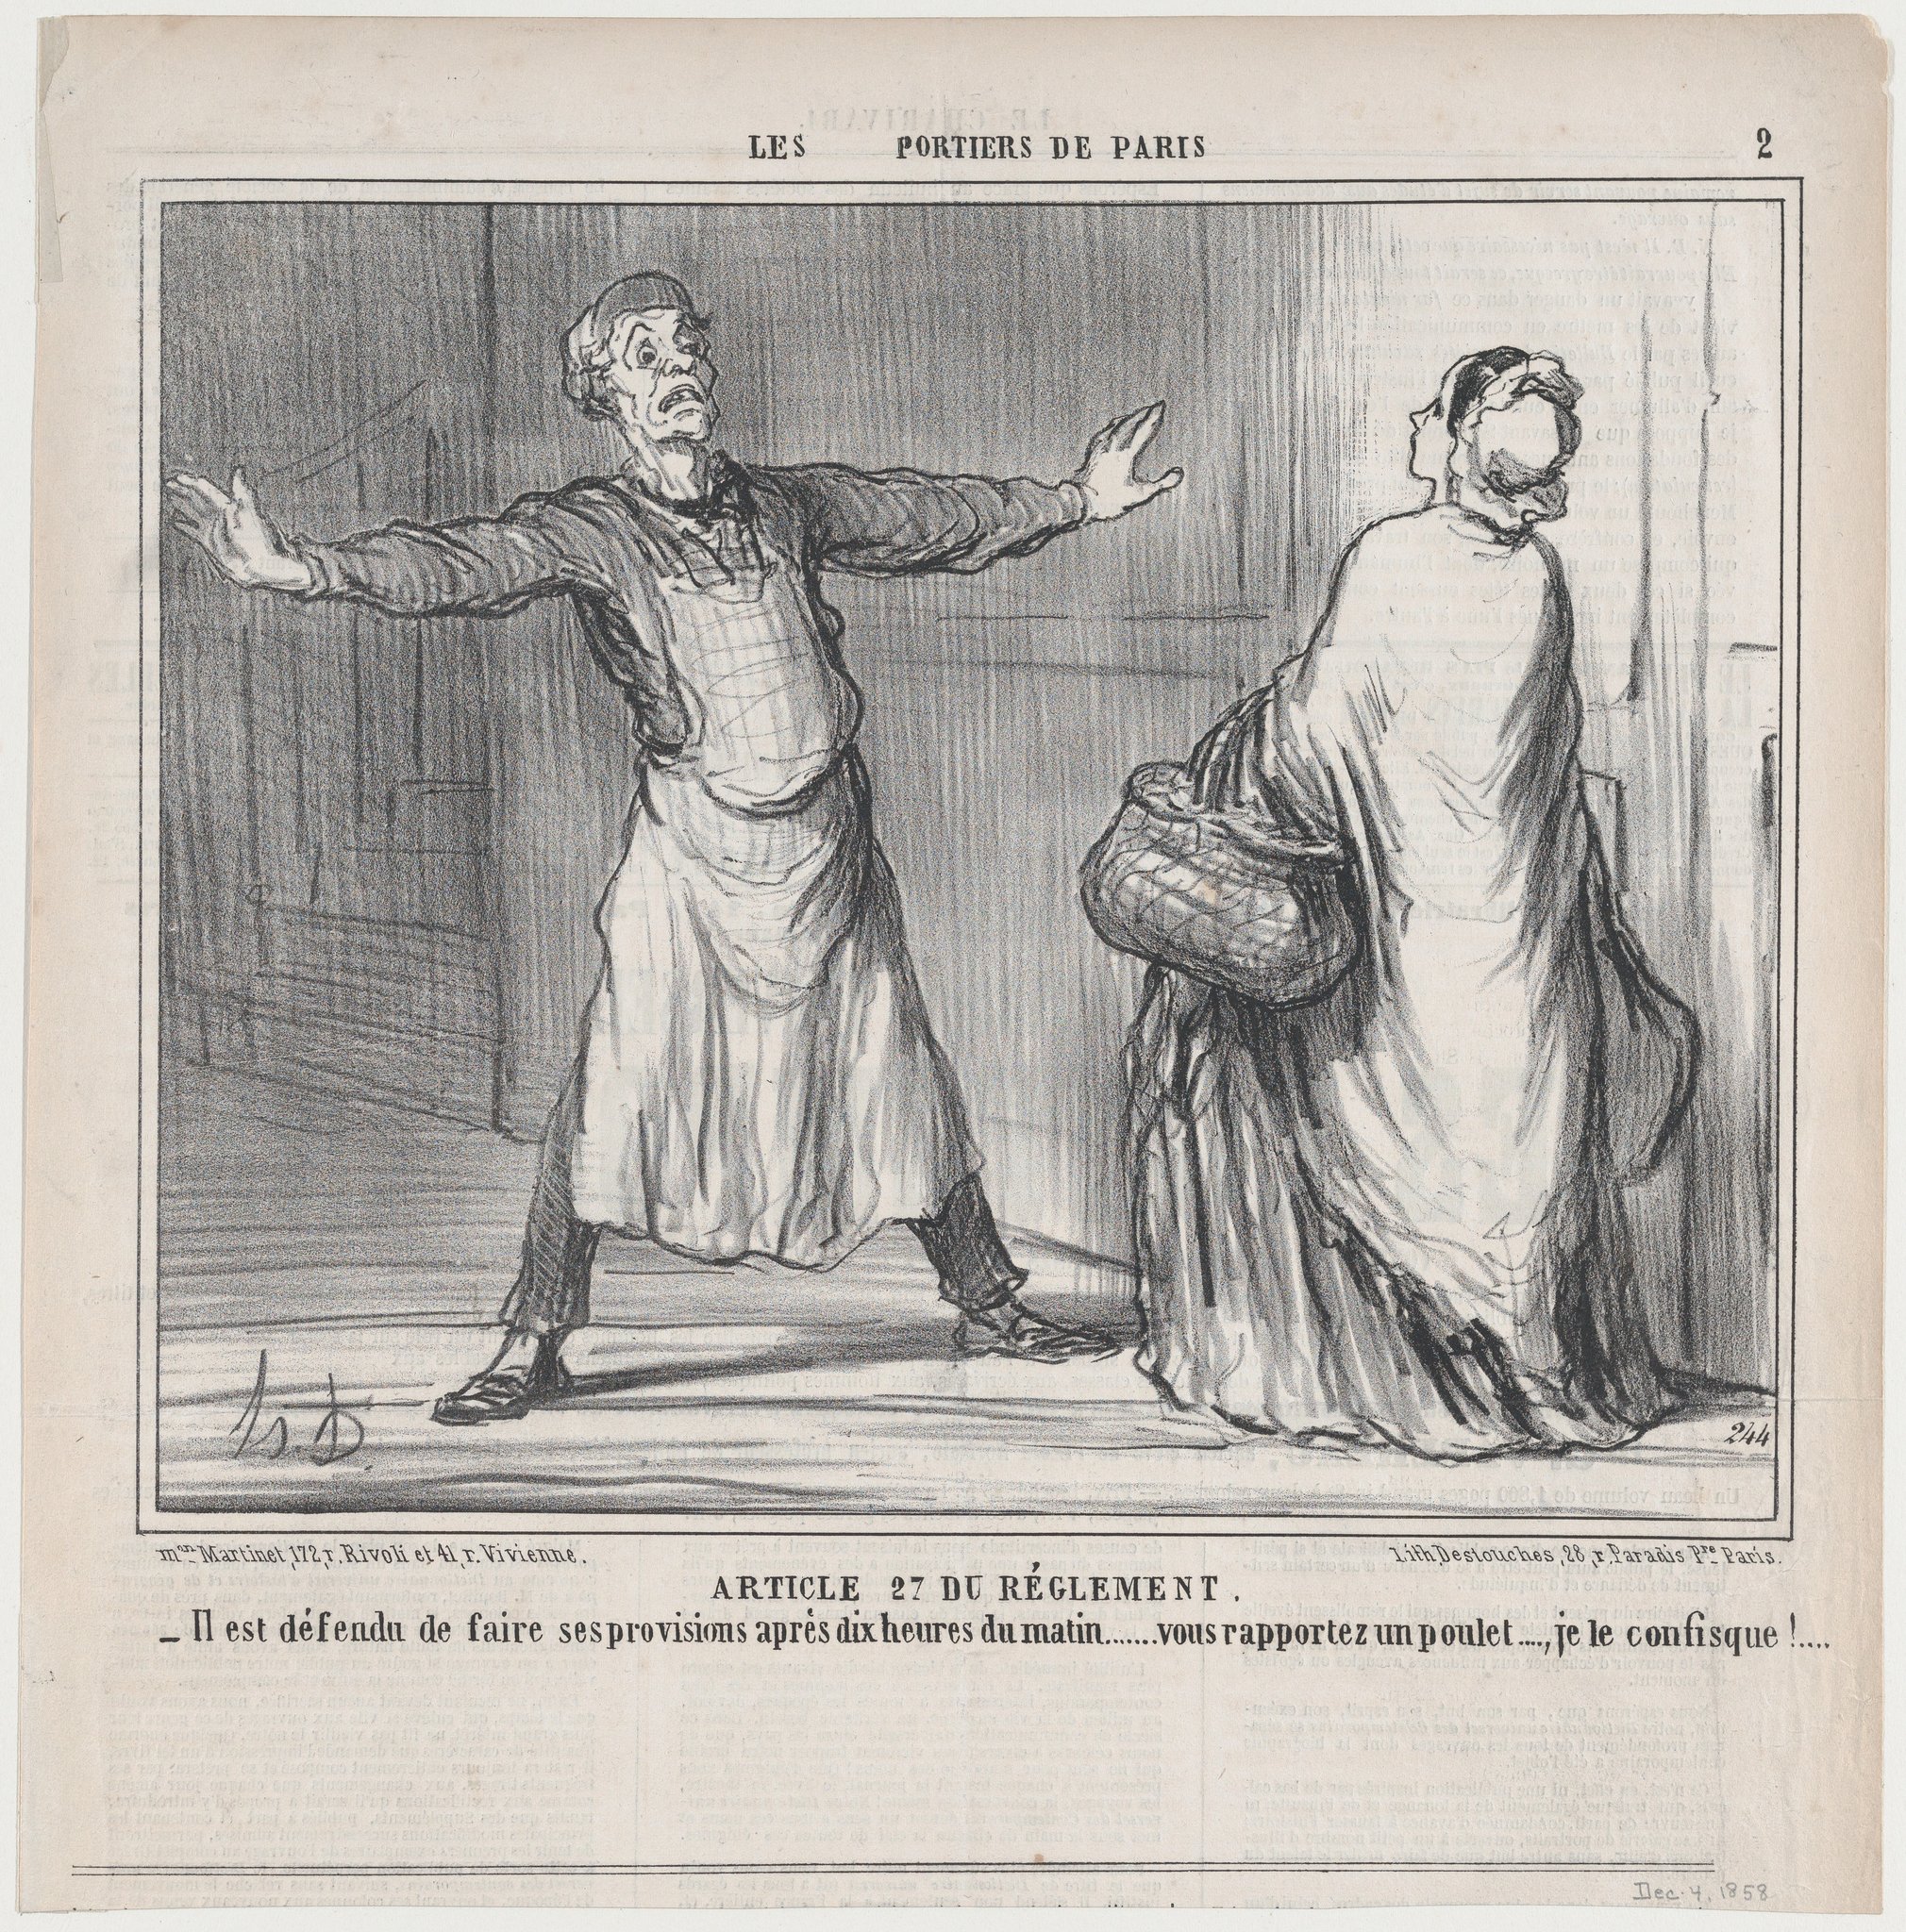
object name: print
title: Article 27 du Réglement, from Les Portiers de Paris, published in Le Charivari, December 4, 1858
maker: honoré daumier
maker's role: artist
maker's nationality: french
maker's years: 1808-1879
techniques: lithograph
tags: men,women